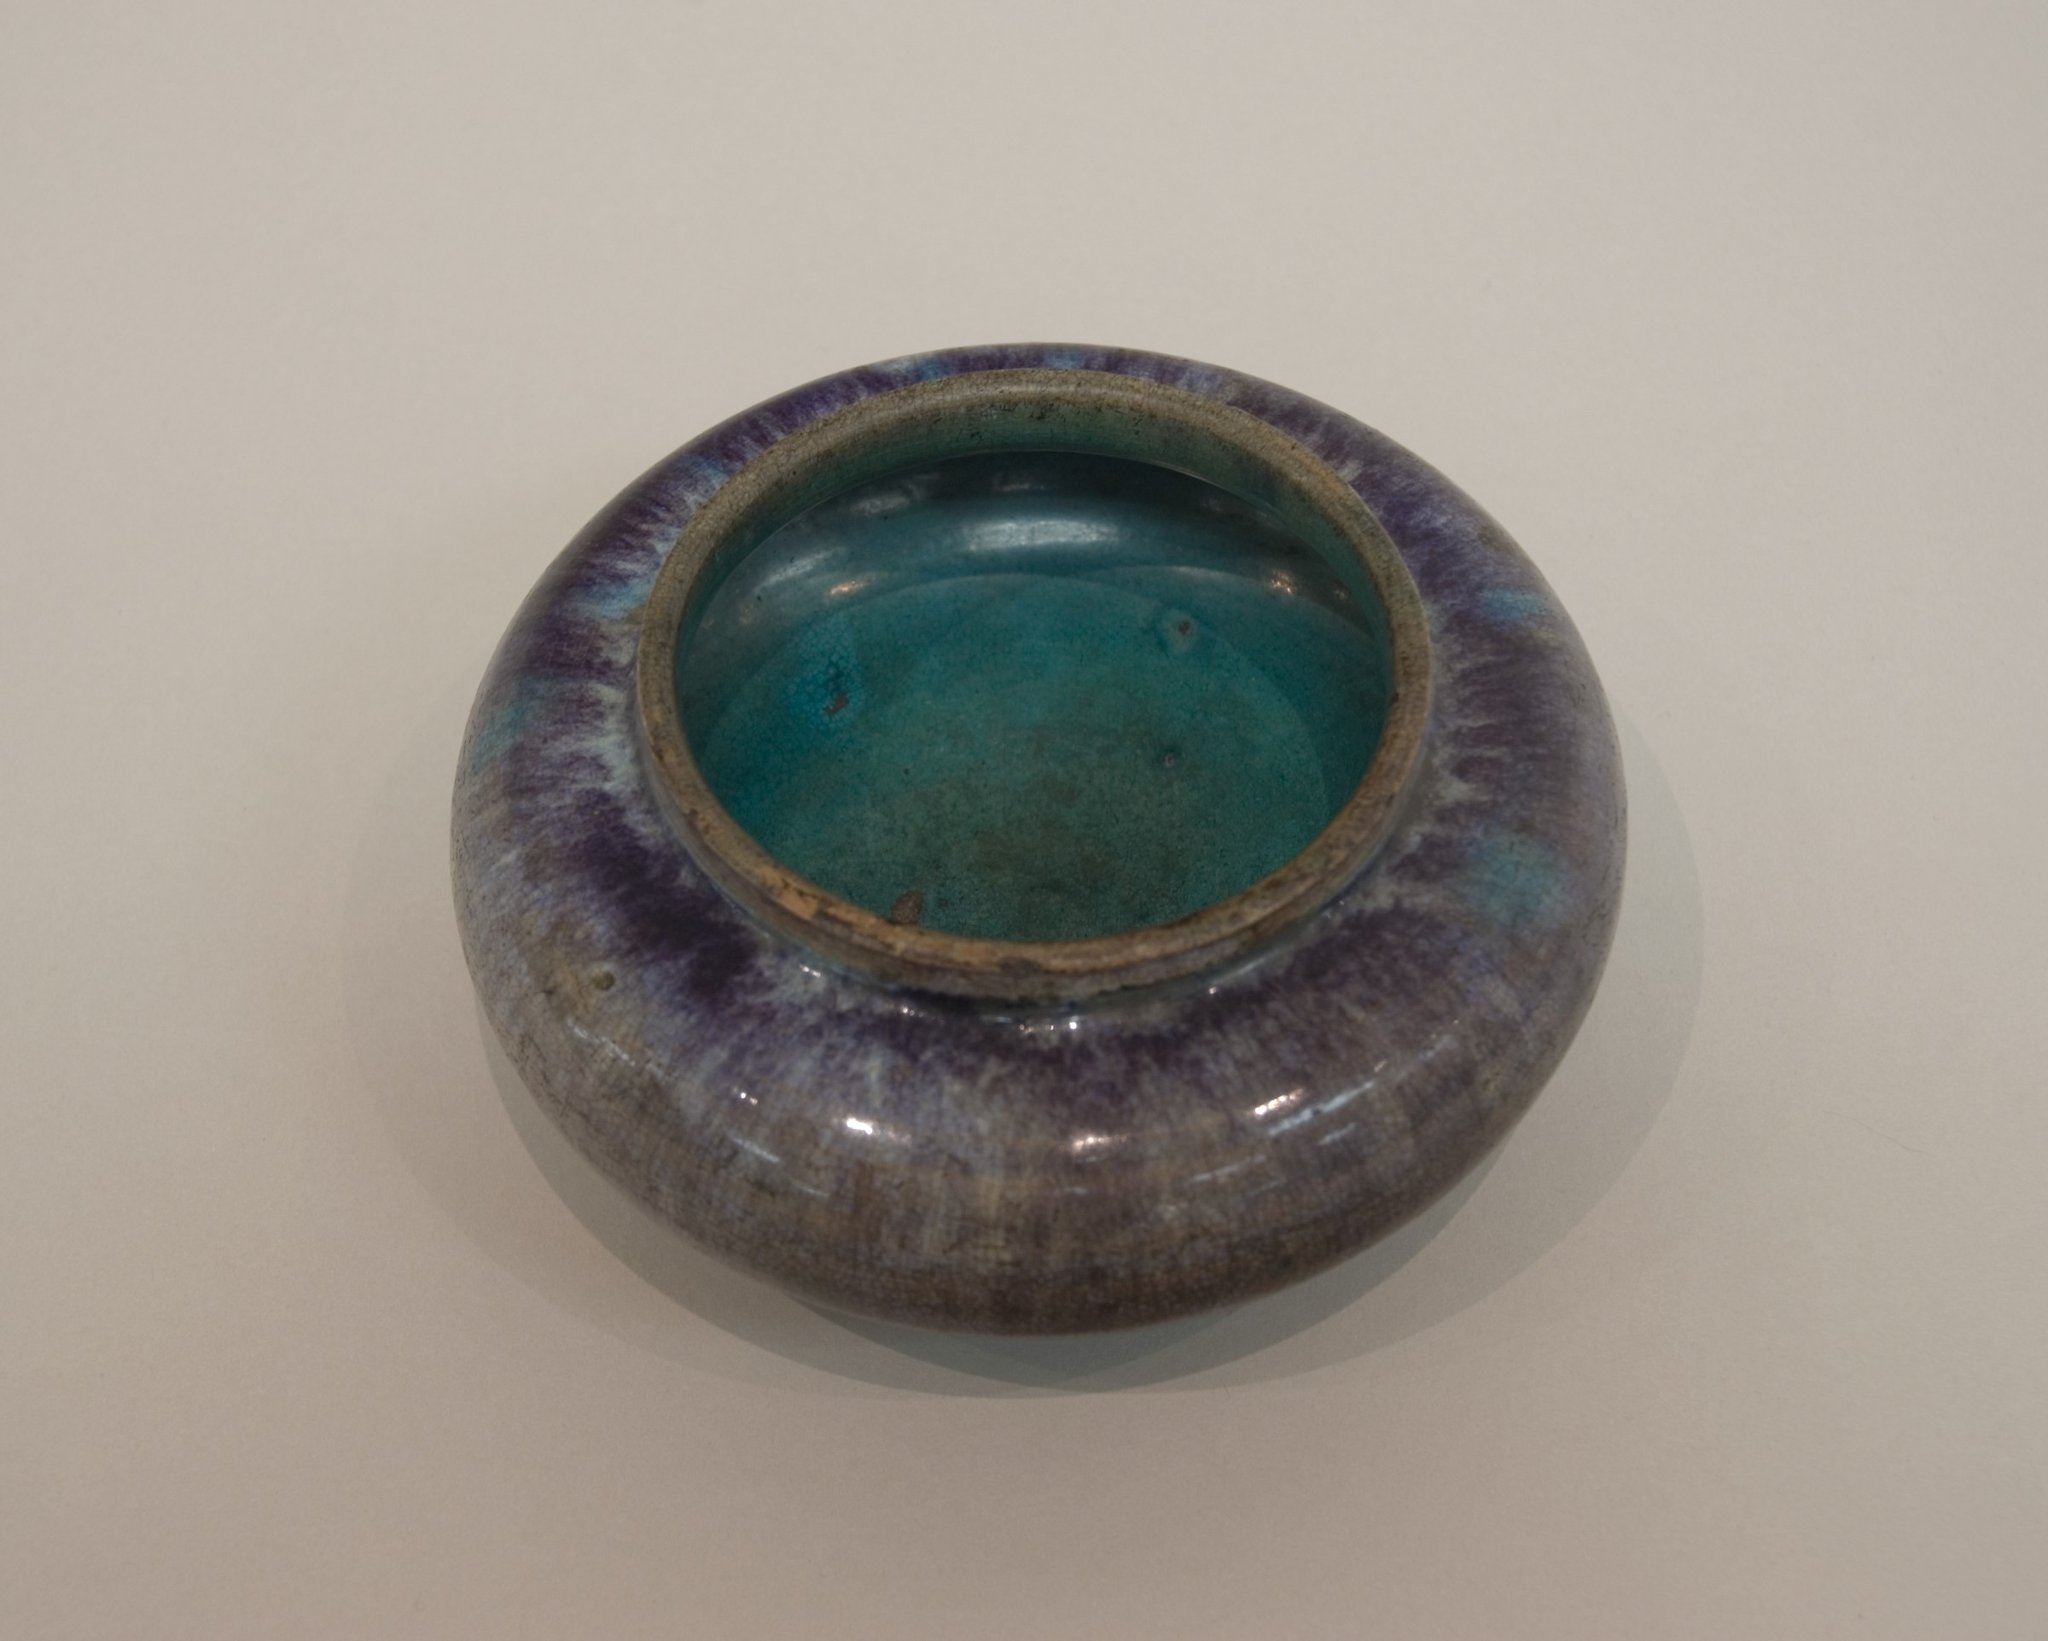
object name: jar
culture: chinese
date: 1801-1900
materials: glaze, stoneware